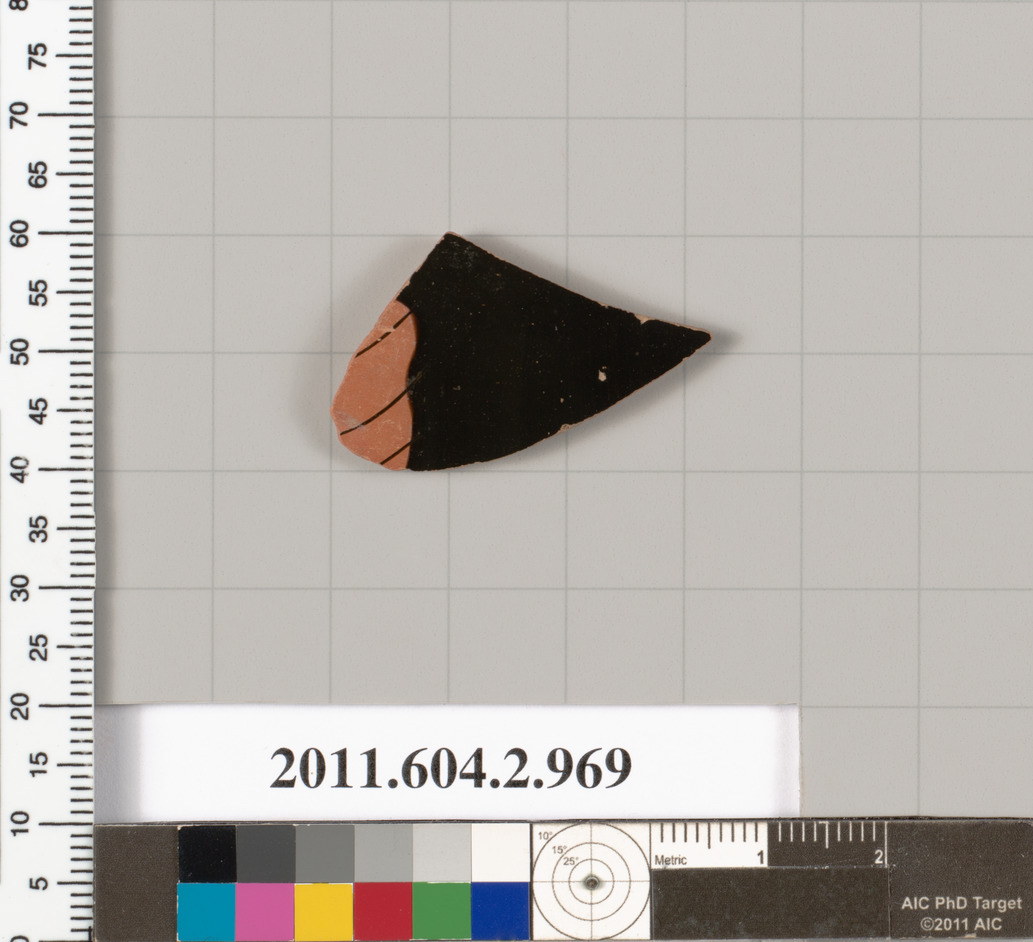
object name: oinochoe fragment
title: Terracotta fragment of an oinochoe (jug)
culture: greek, attic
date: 475-451 BCE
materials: terracotta